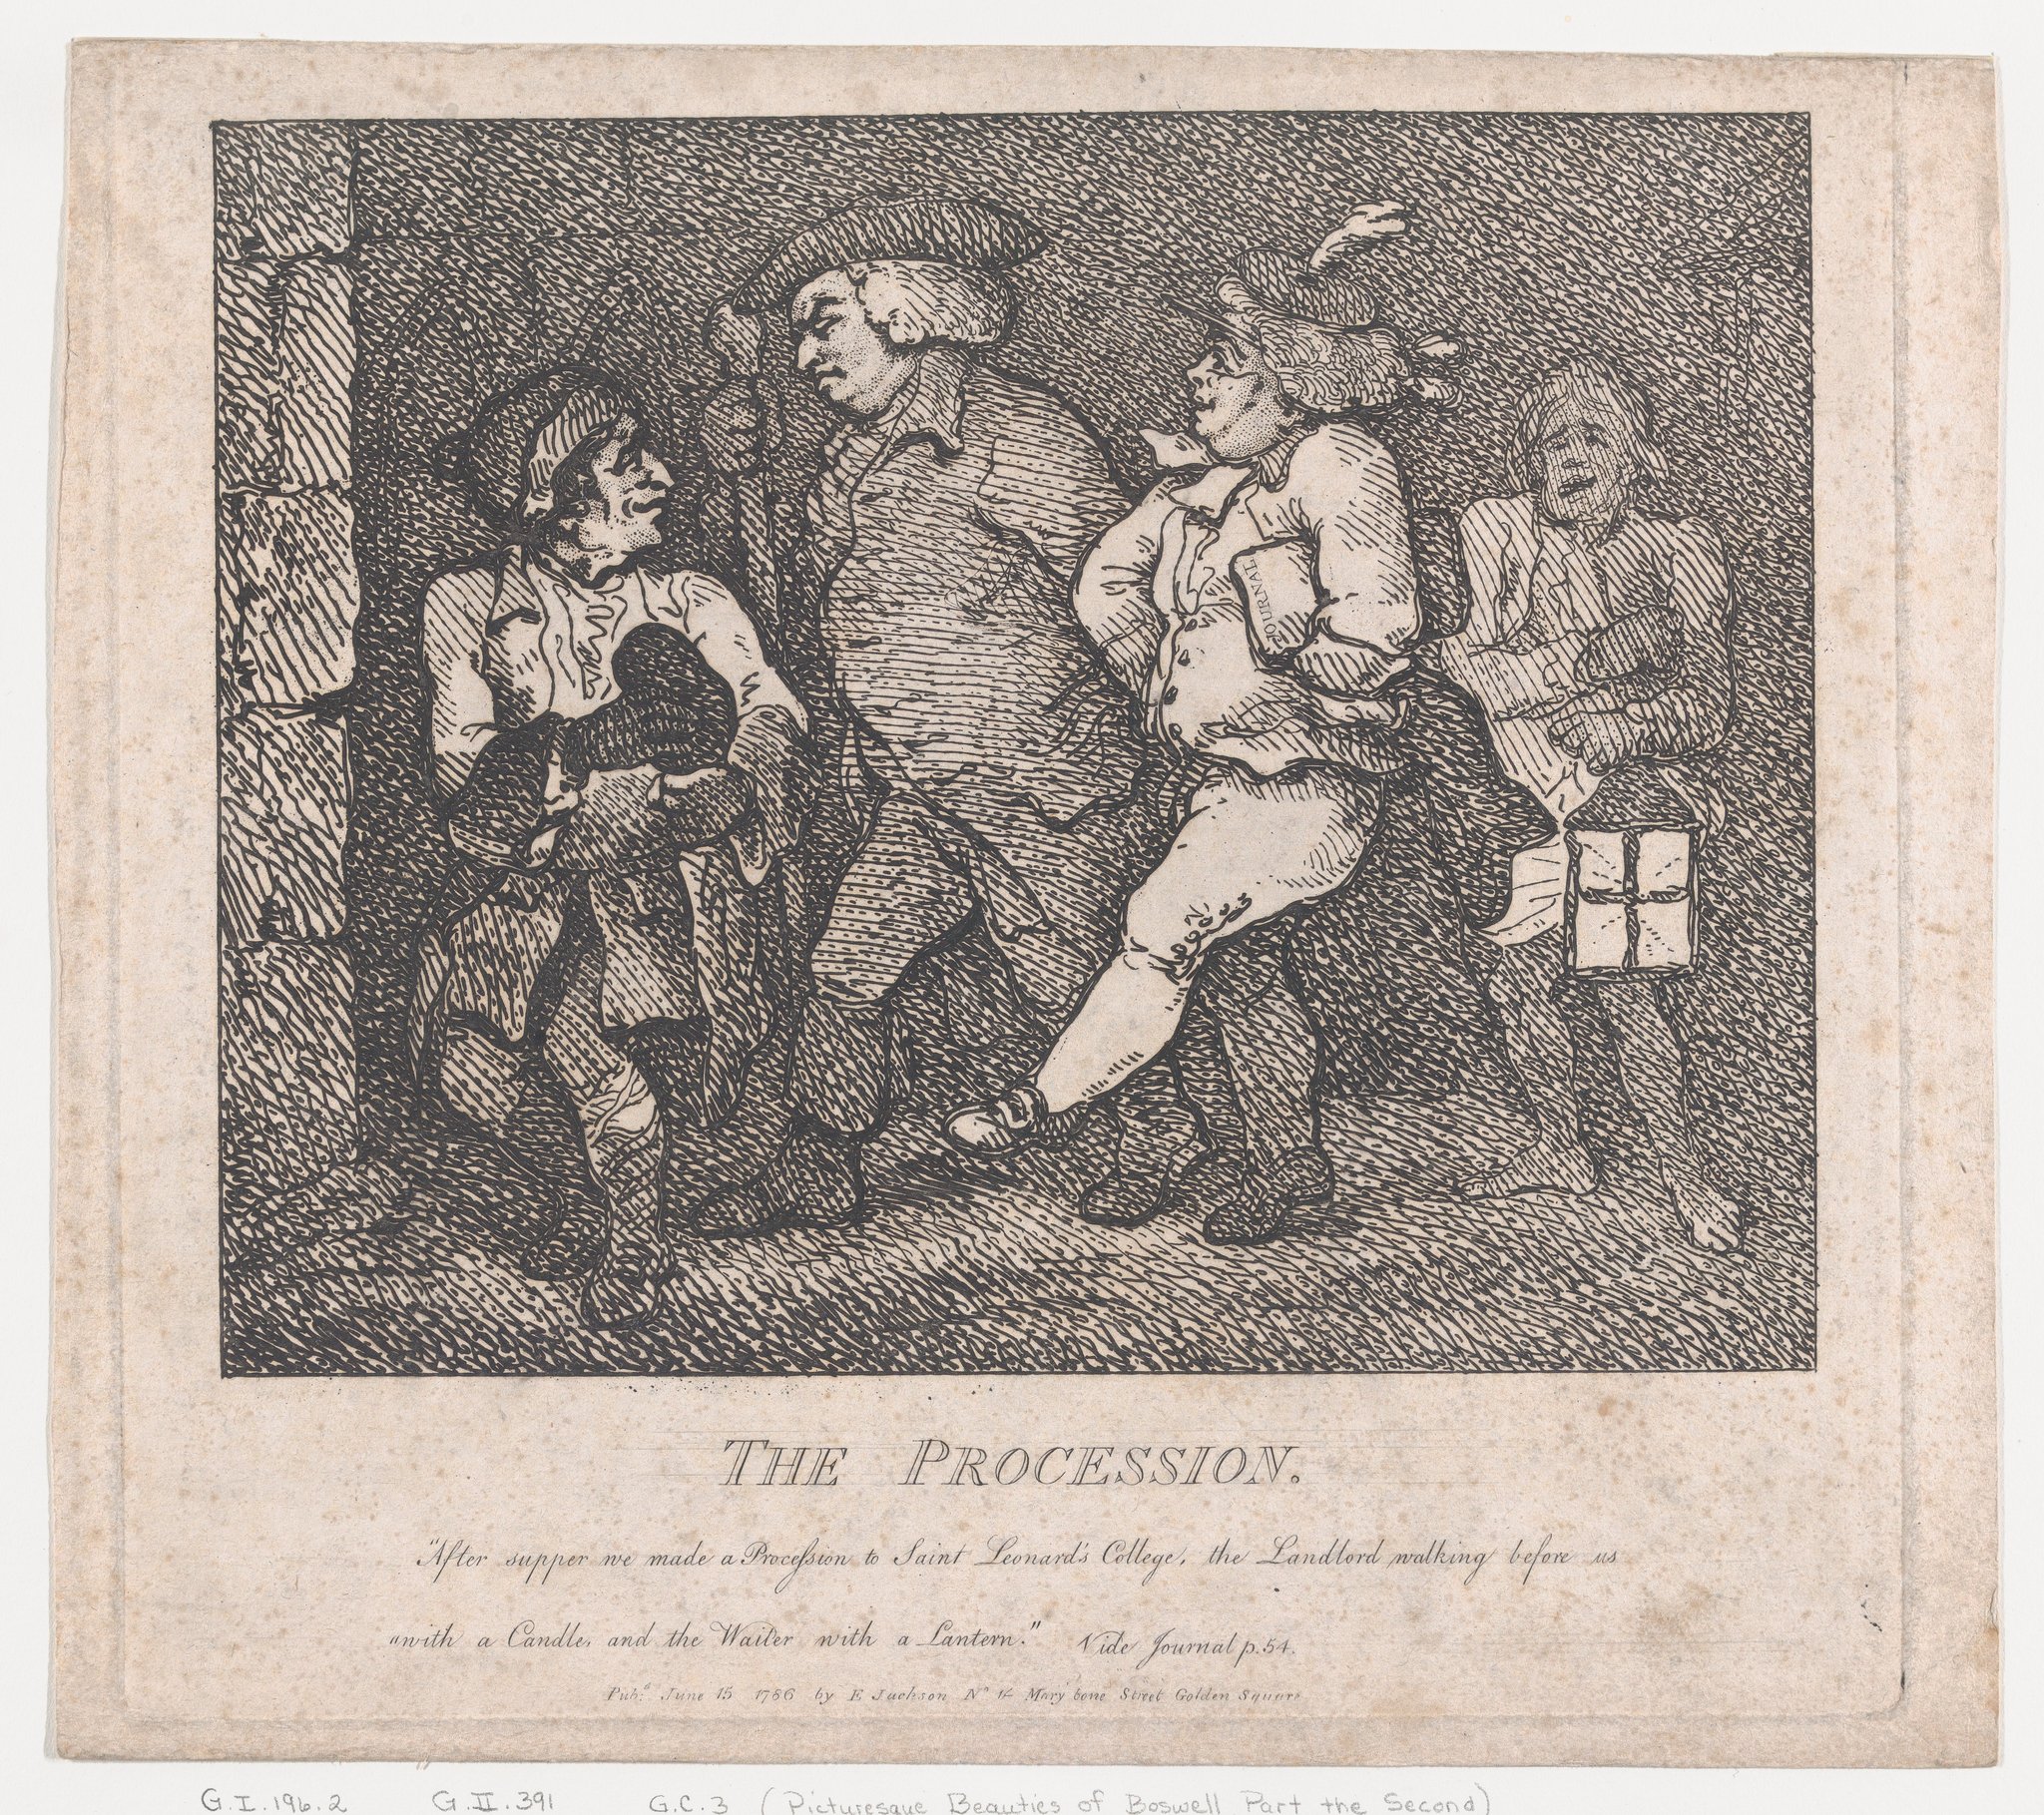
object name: print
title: The Procession (Picturesque Beauties of Boswell, Part the Second)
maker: thomas rowlandson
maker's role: artist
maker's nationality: british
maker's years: 1757-1827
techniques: etching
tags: men